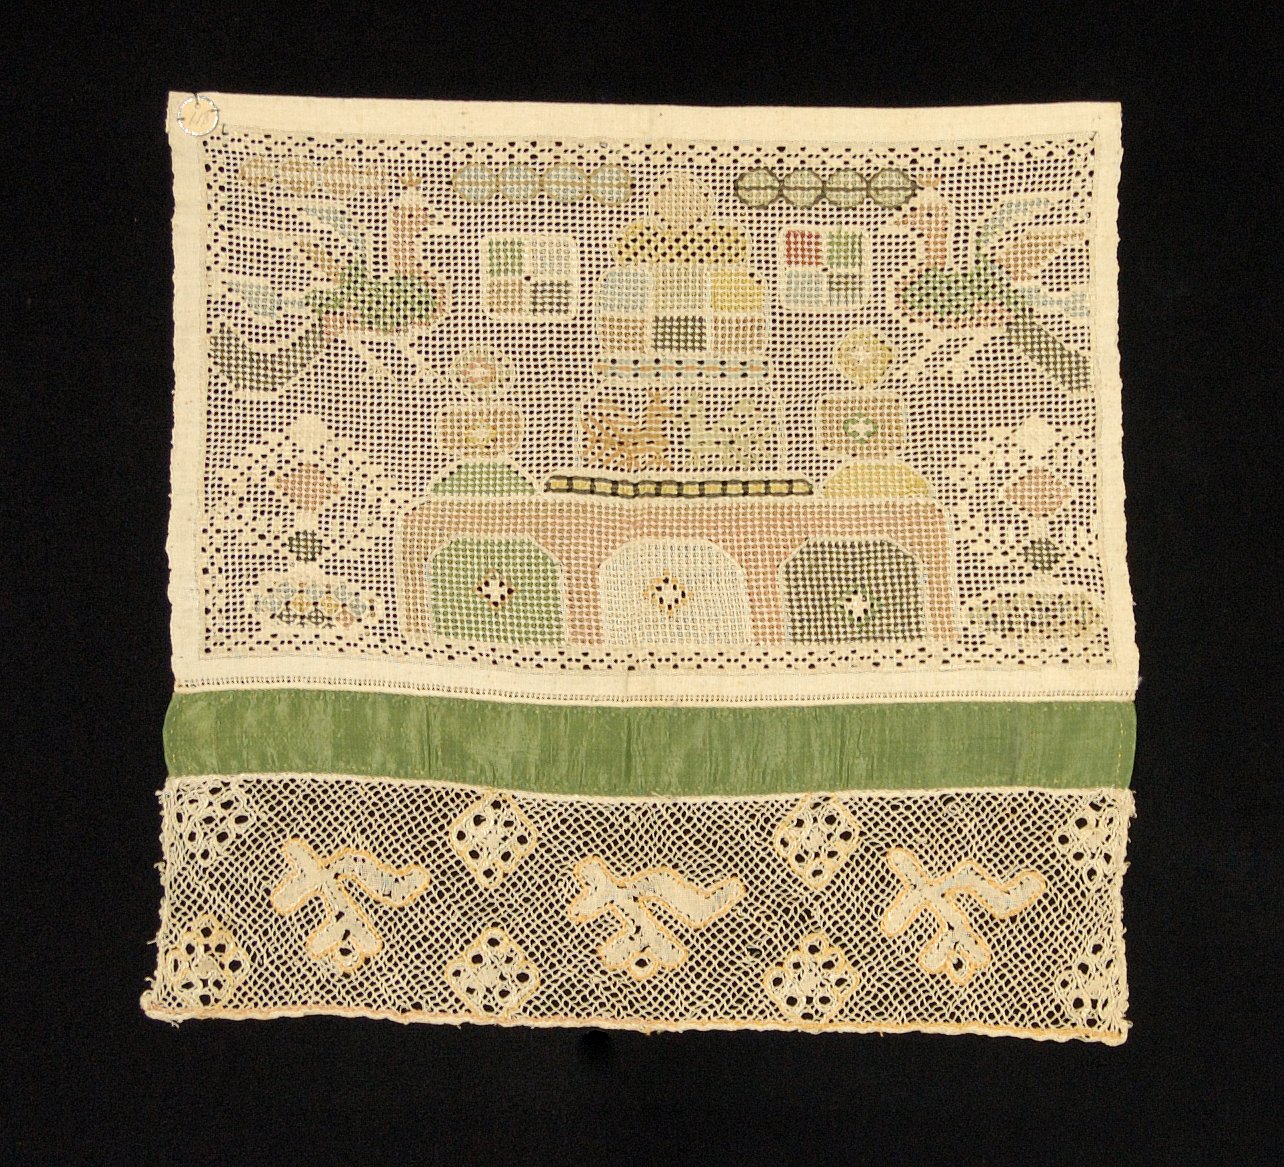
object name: border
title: Towel border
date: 1800-1850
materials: linen, silk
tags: birds,buildings